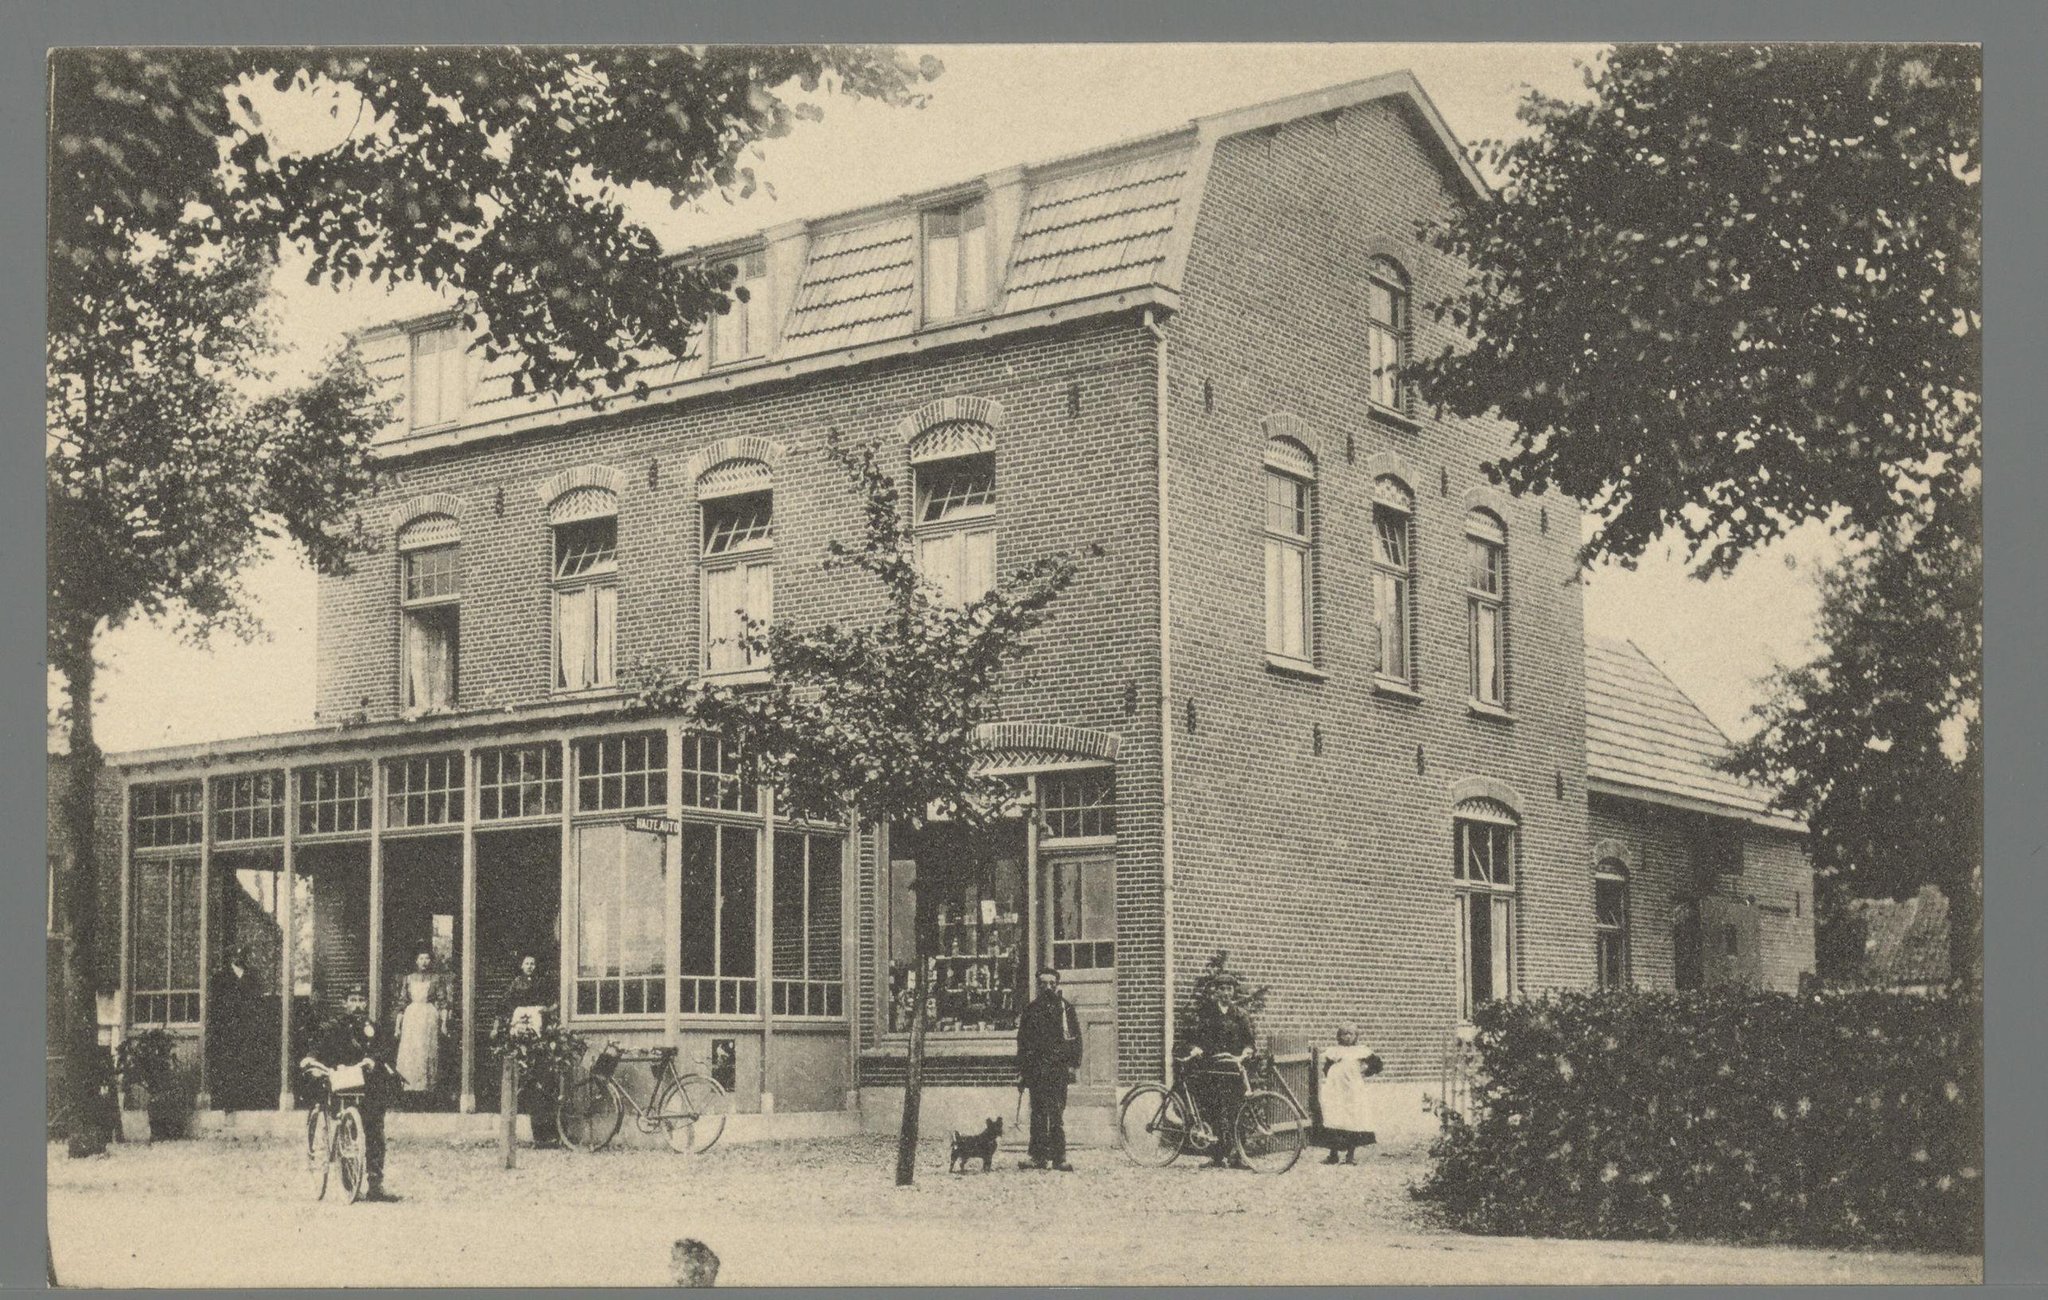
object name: ansichtkaart, prentbriefkaart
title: Hotel Pension "Mookerheide". J.H. Hendriks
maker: Anonymous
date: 1905-1930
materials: cardboard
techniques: photograph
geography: cuijk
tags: hotel, hostelry, inn